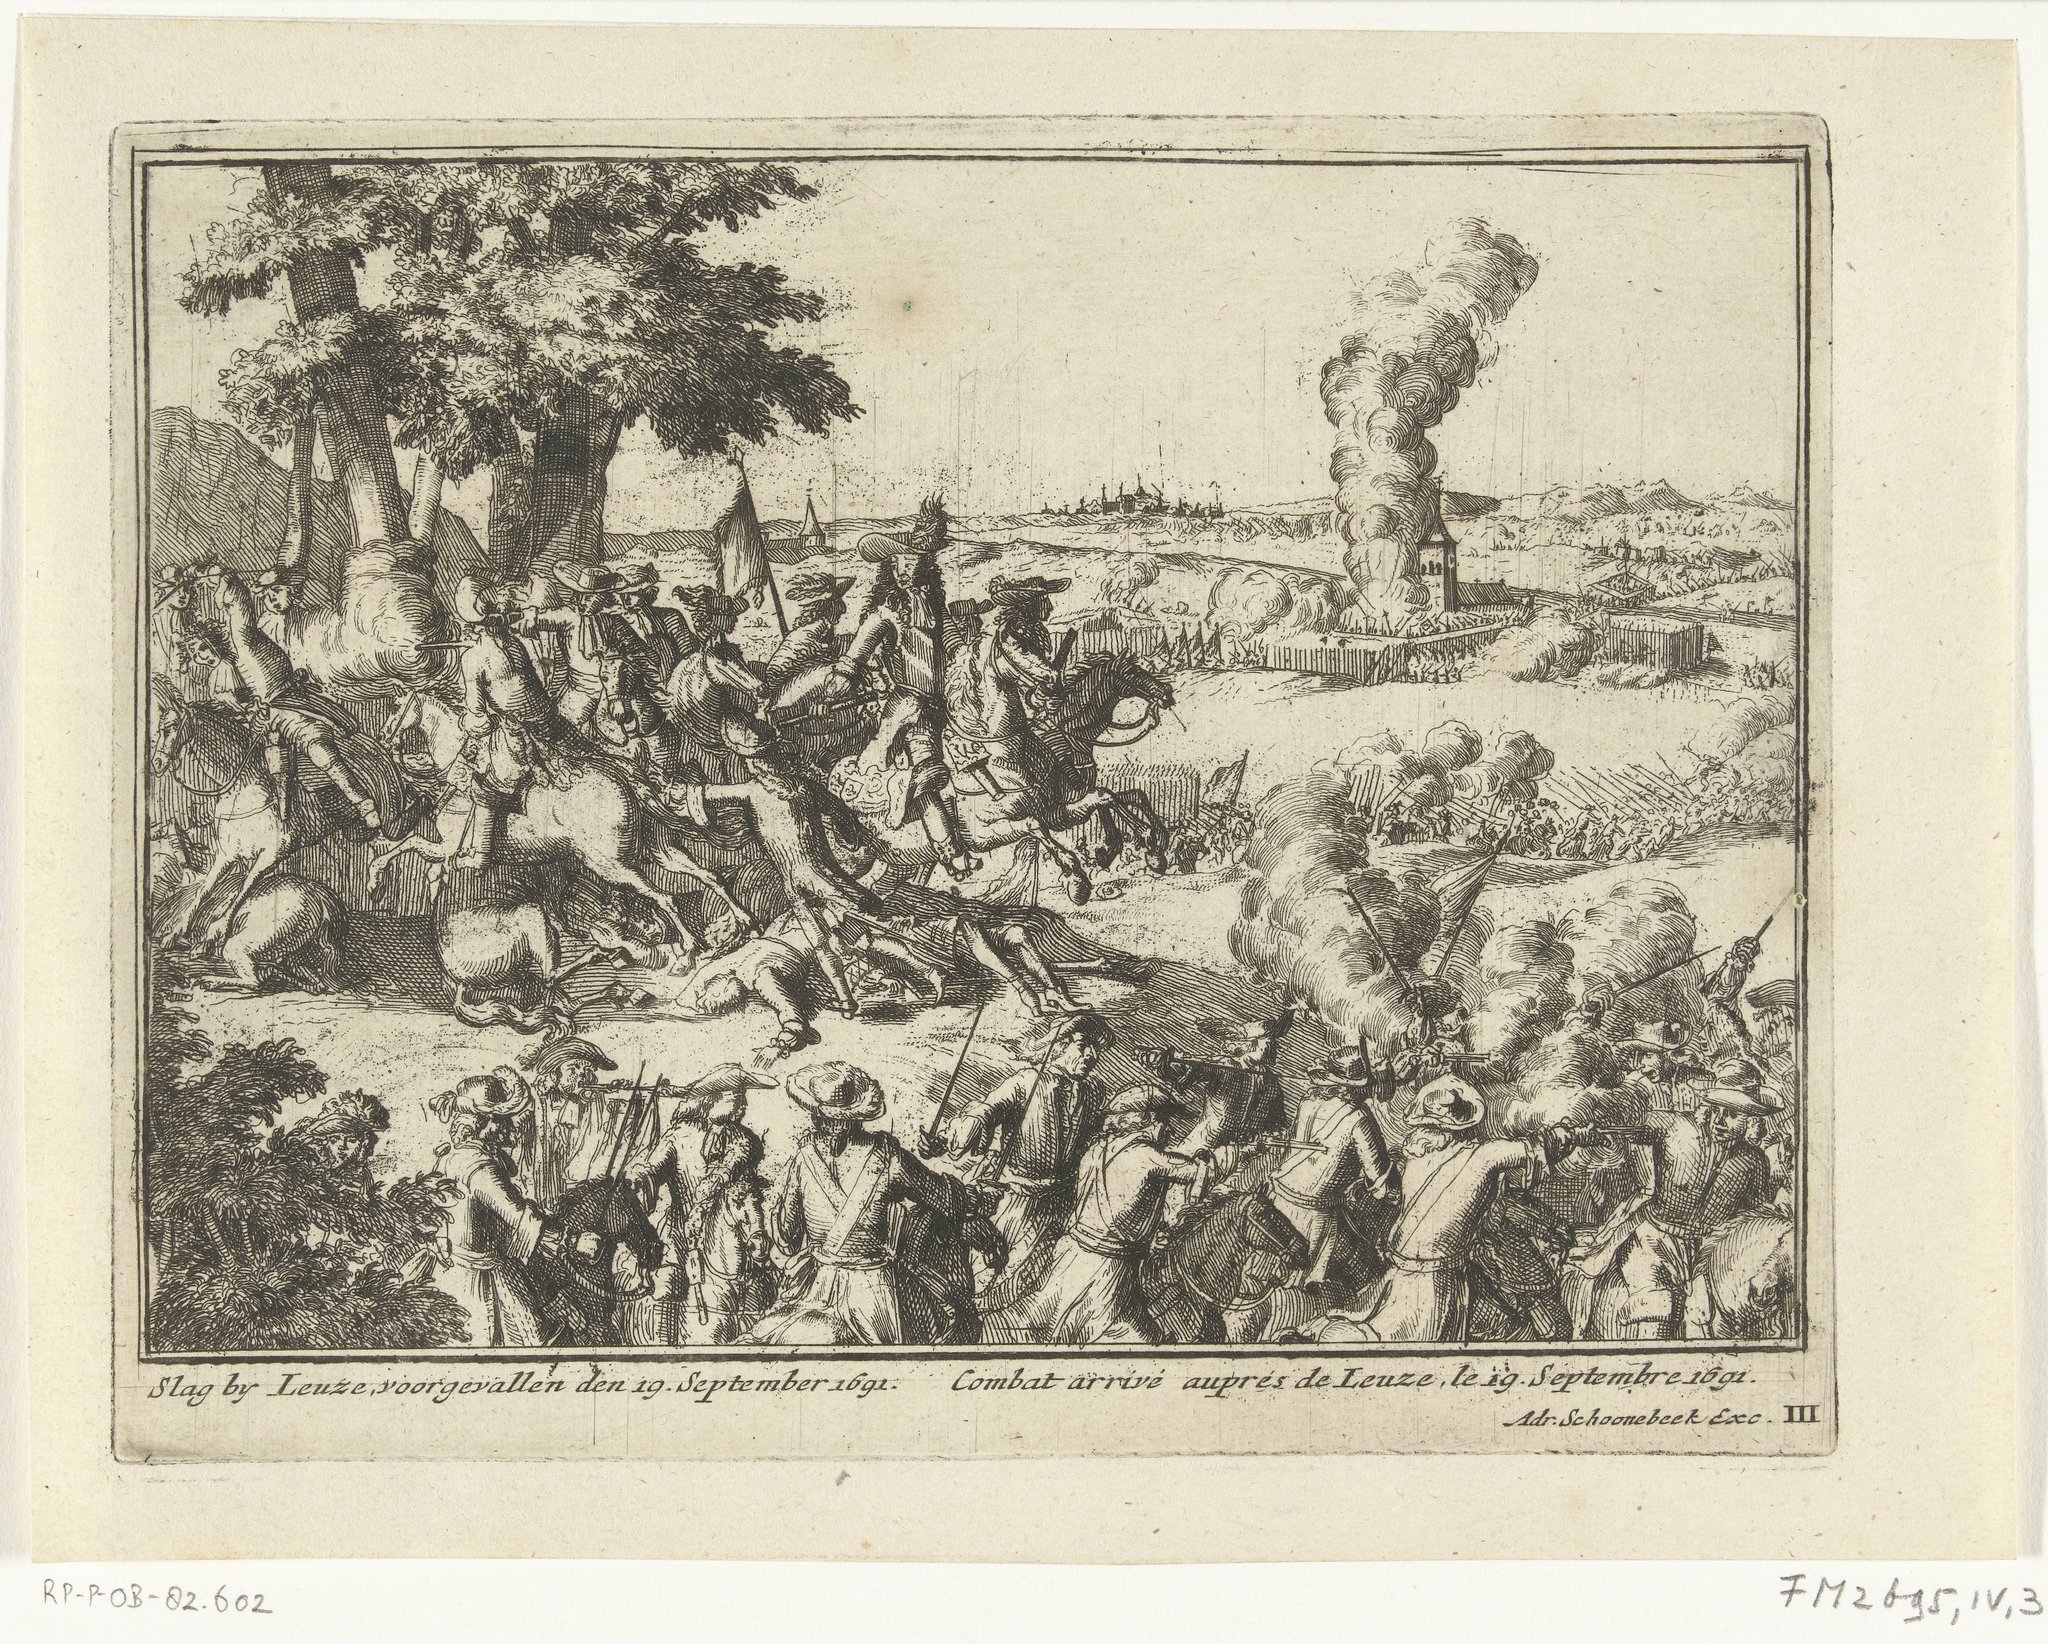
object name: print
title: Slag bij Leuze, 1691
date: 1695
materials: paper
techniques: etching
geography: amsterdam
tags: the hague, william iii (prince of orange and king of england, scotland, and ireland), battle (+ land forces)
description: Het leger van koning Willem III in de slag bij Leuze tijdens de Negenjarige Oorlog, de stad wordt op 19 september veroverd. Plaat nr. III in de serie 'Engelands schouwtoneel' over oorlogen gevoerd door Willem III in de jaren 1691-1695 na de Glorious Revolution, (vierde deel). Met onderschriften in het Nederlands en Frans.